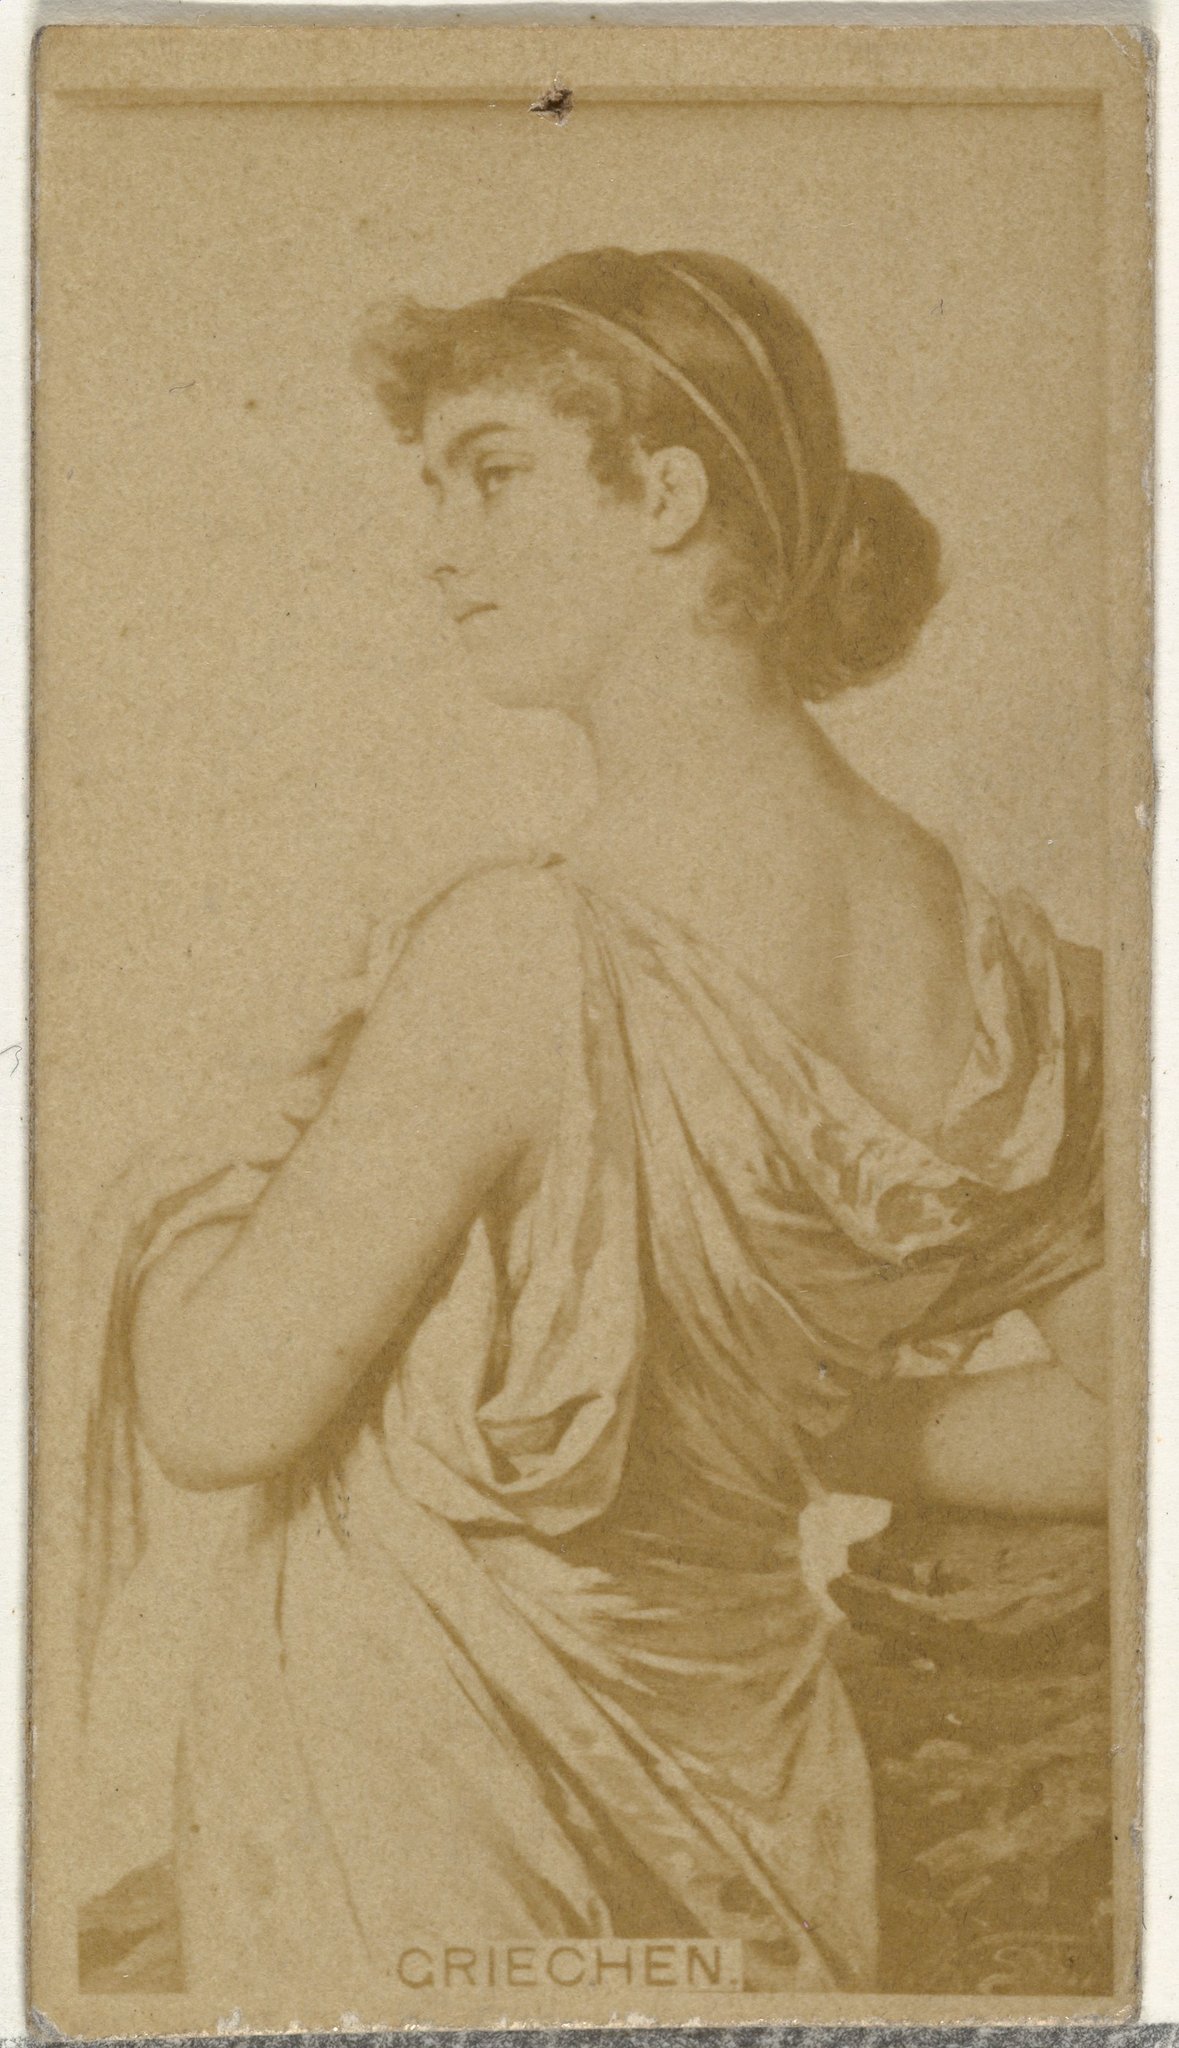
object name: photograph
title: Griechen, from the Actors and Actresses series (N145-8) issued by Duke Sons & Co. to promote Duke Cigarettes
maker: w. duke, sons & co.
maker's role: publisher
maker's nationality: american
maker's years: 1870-1920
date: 1891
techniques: albumen silver print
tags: portraits,women,actresses